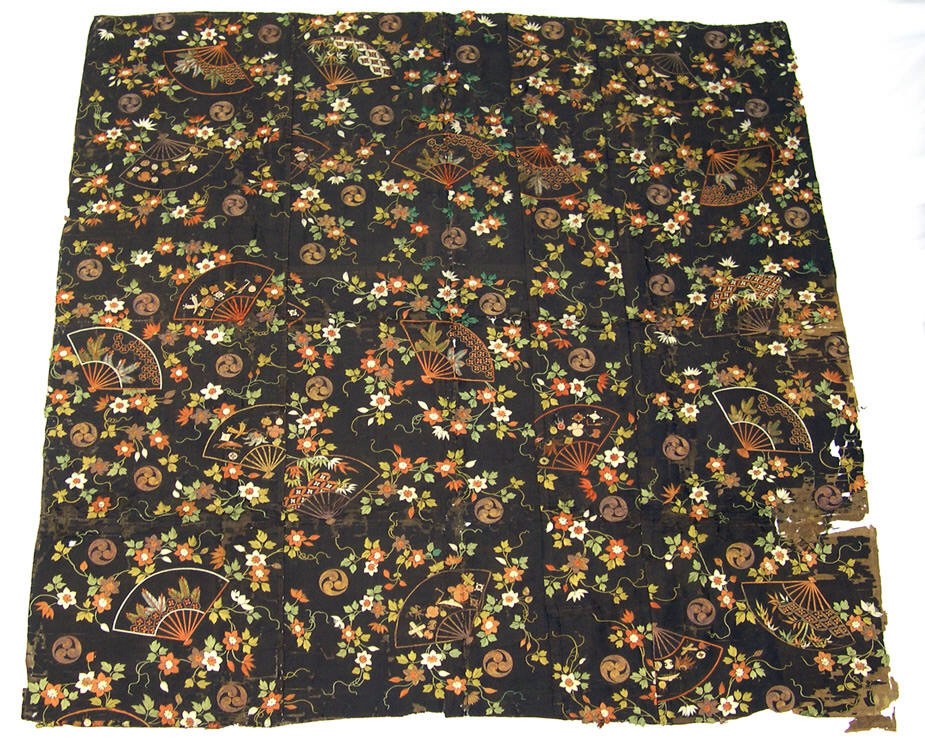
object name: panel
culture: japanese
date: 1600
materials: metal thread, silk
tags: fans,flowers